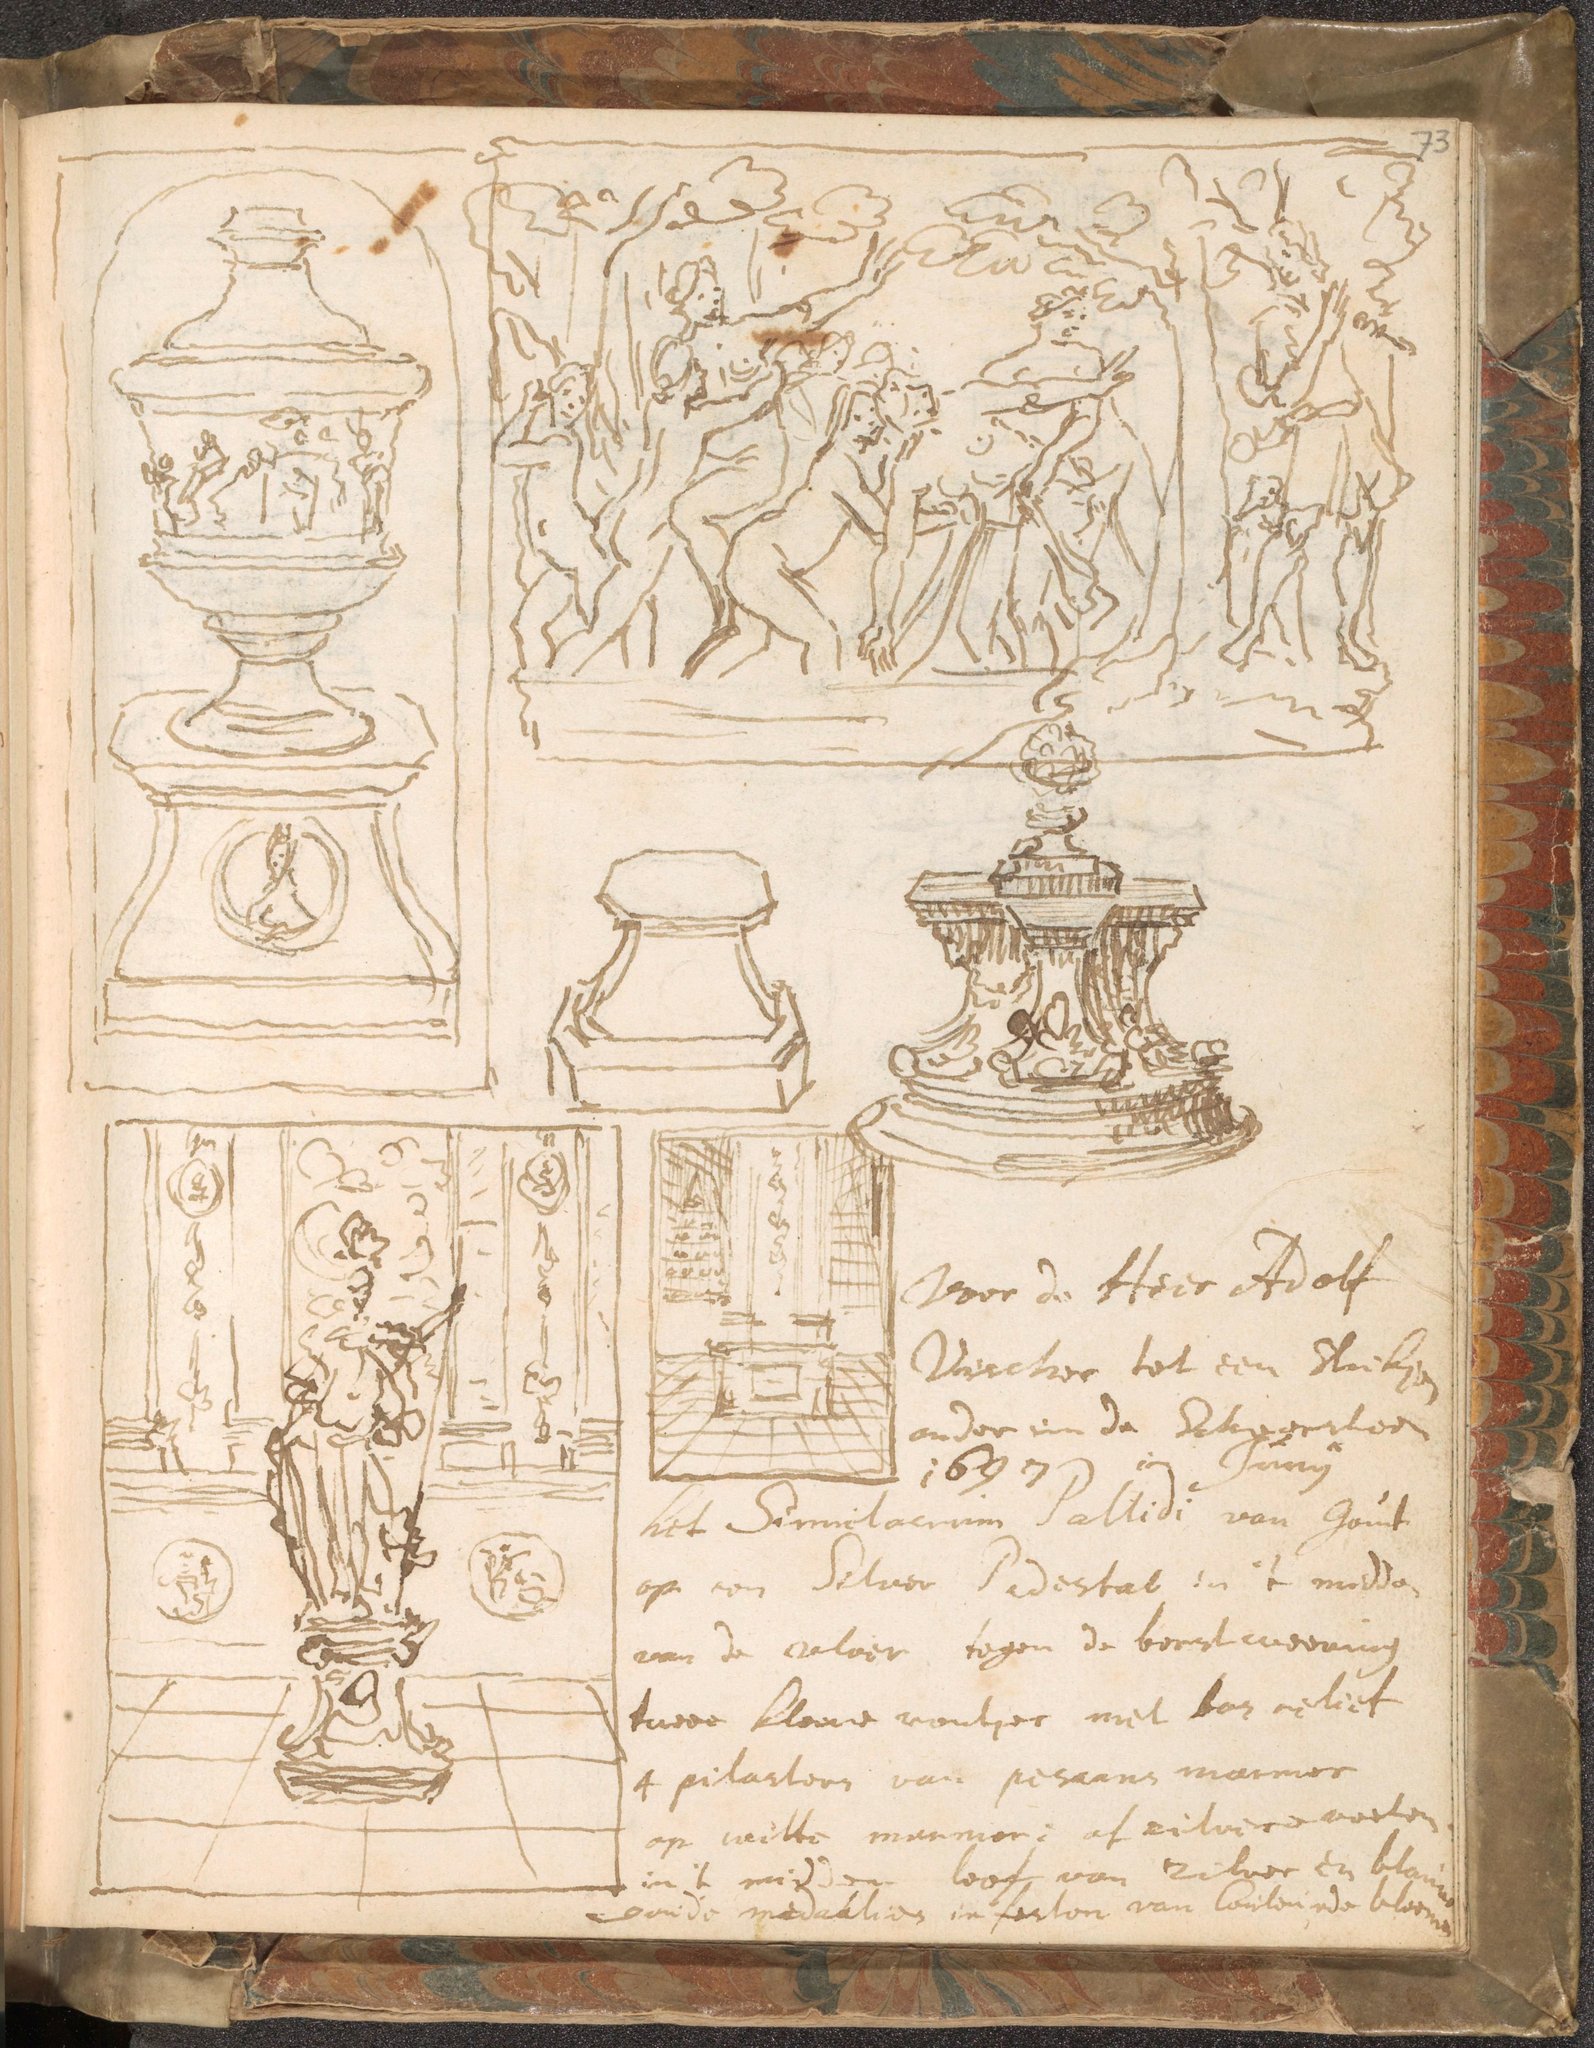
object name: diary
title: Handschrift met schetsen voor opdrachten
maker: philip tidemann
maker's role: draughtsman, painter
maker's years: 1657-1705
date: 1694-1697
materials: cardboard, chalk, paper, parchment, pencil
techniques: pen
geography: amsterdam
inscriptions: bookplate: ‘V.DELA:MoNTAGNE EX.LIBRIS’, inscription: ‘Philiph. Tidemann 1690 / Amsterdam’, collector's mark: Lugt 2166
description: Aantekenboek van Philip Tiedeman met schetsen voor opdrachten uit de jaren 1694-1697. Ontwerpen voor: titelpaginas, schilderijen, waaiers, spelkaarten, interieurs en prenten. In band van perkament bekleed met gemarmerd papier.